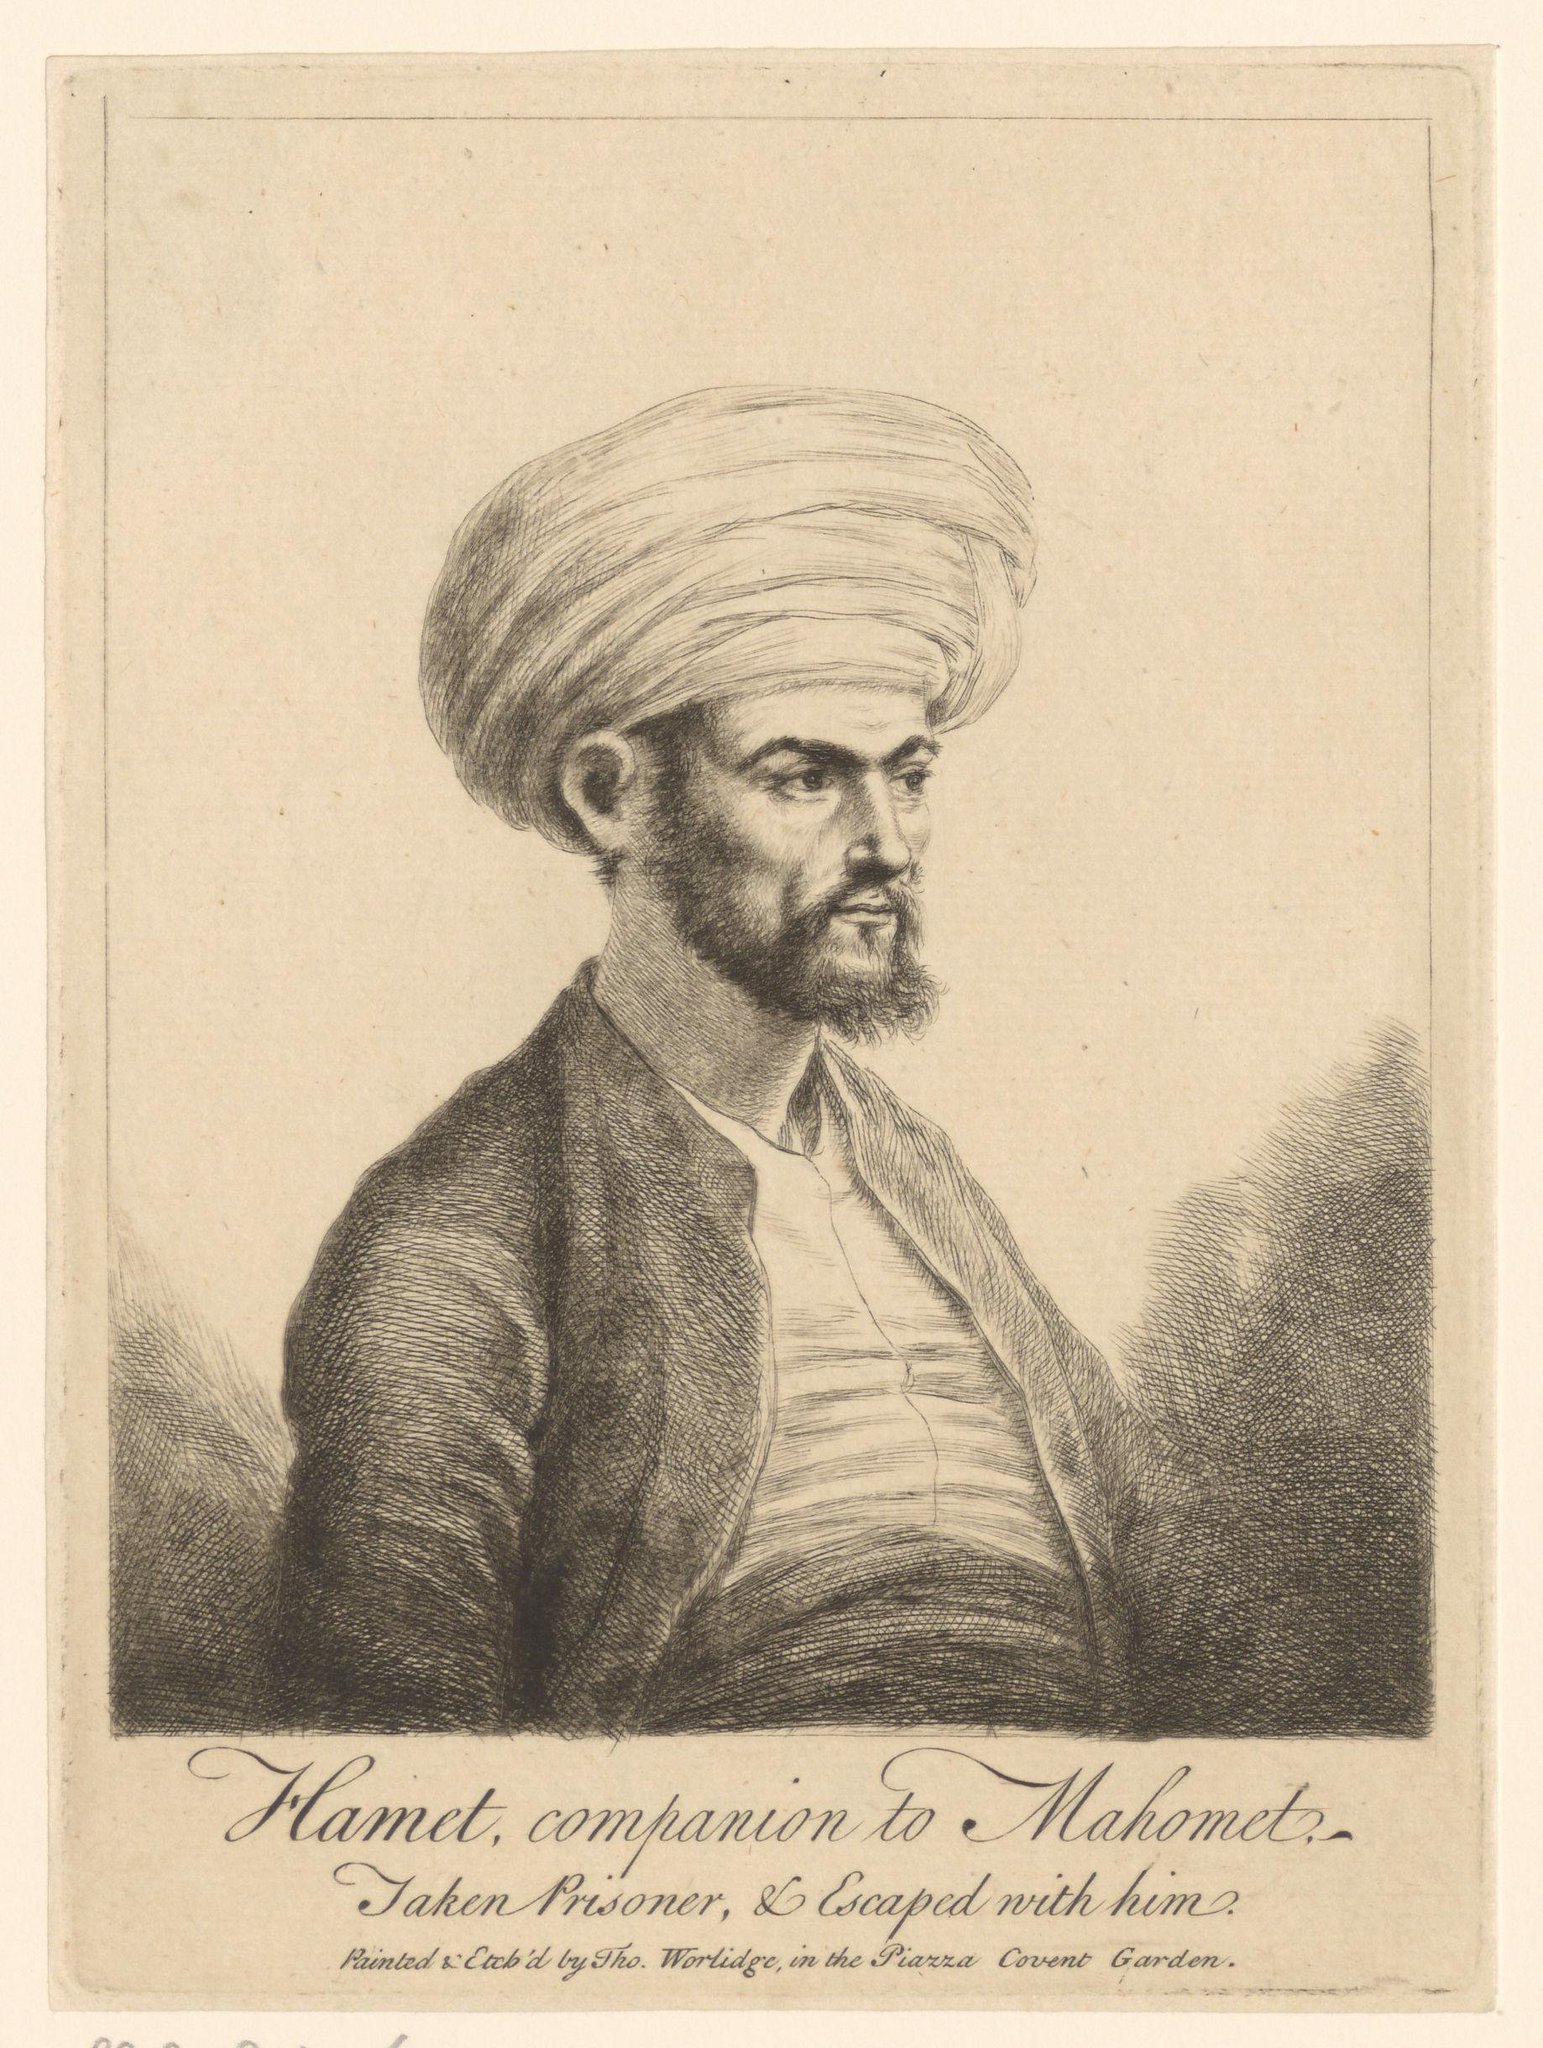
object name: print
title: Portret van Hamet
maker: thomas worlidge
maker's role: print maker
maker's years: 1700-1766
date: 1710-1766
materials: paper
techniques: drypoint, etching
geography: london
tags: historical persons, head-gear: turban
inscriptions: collector's mark: Lugt 240